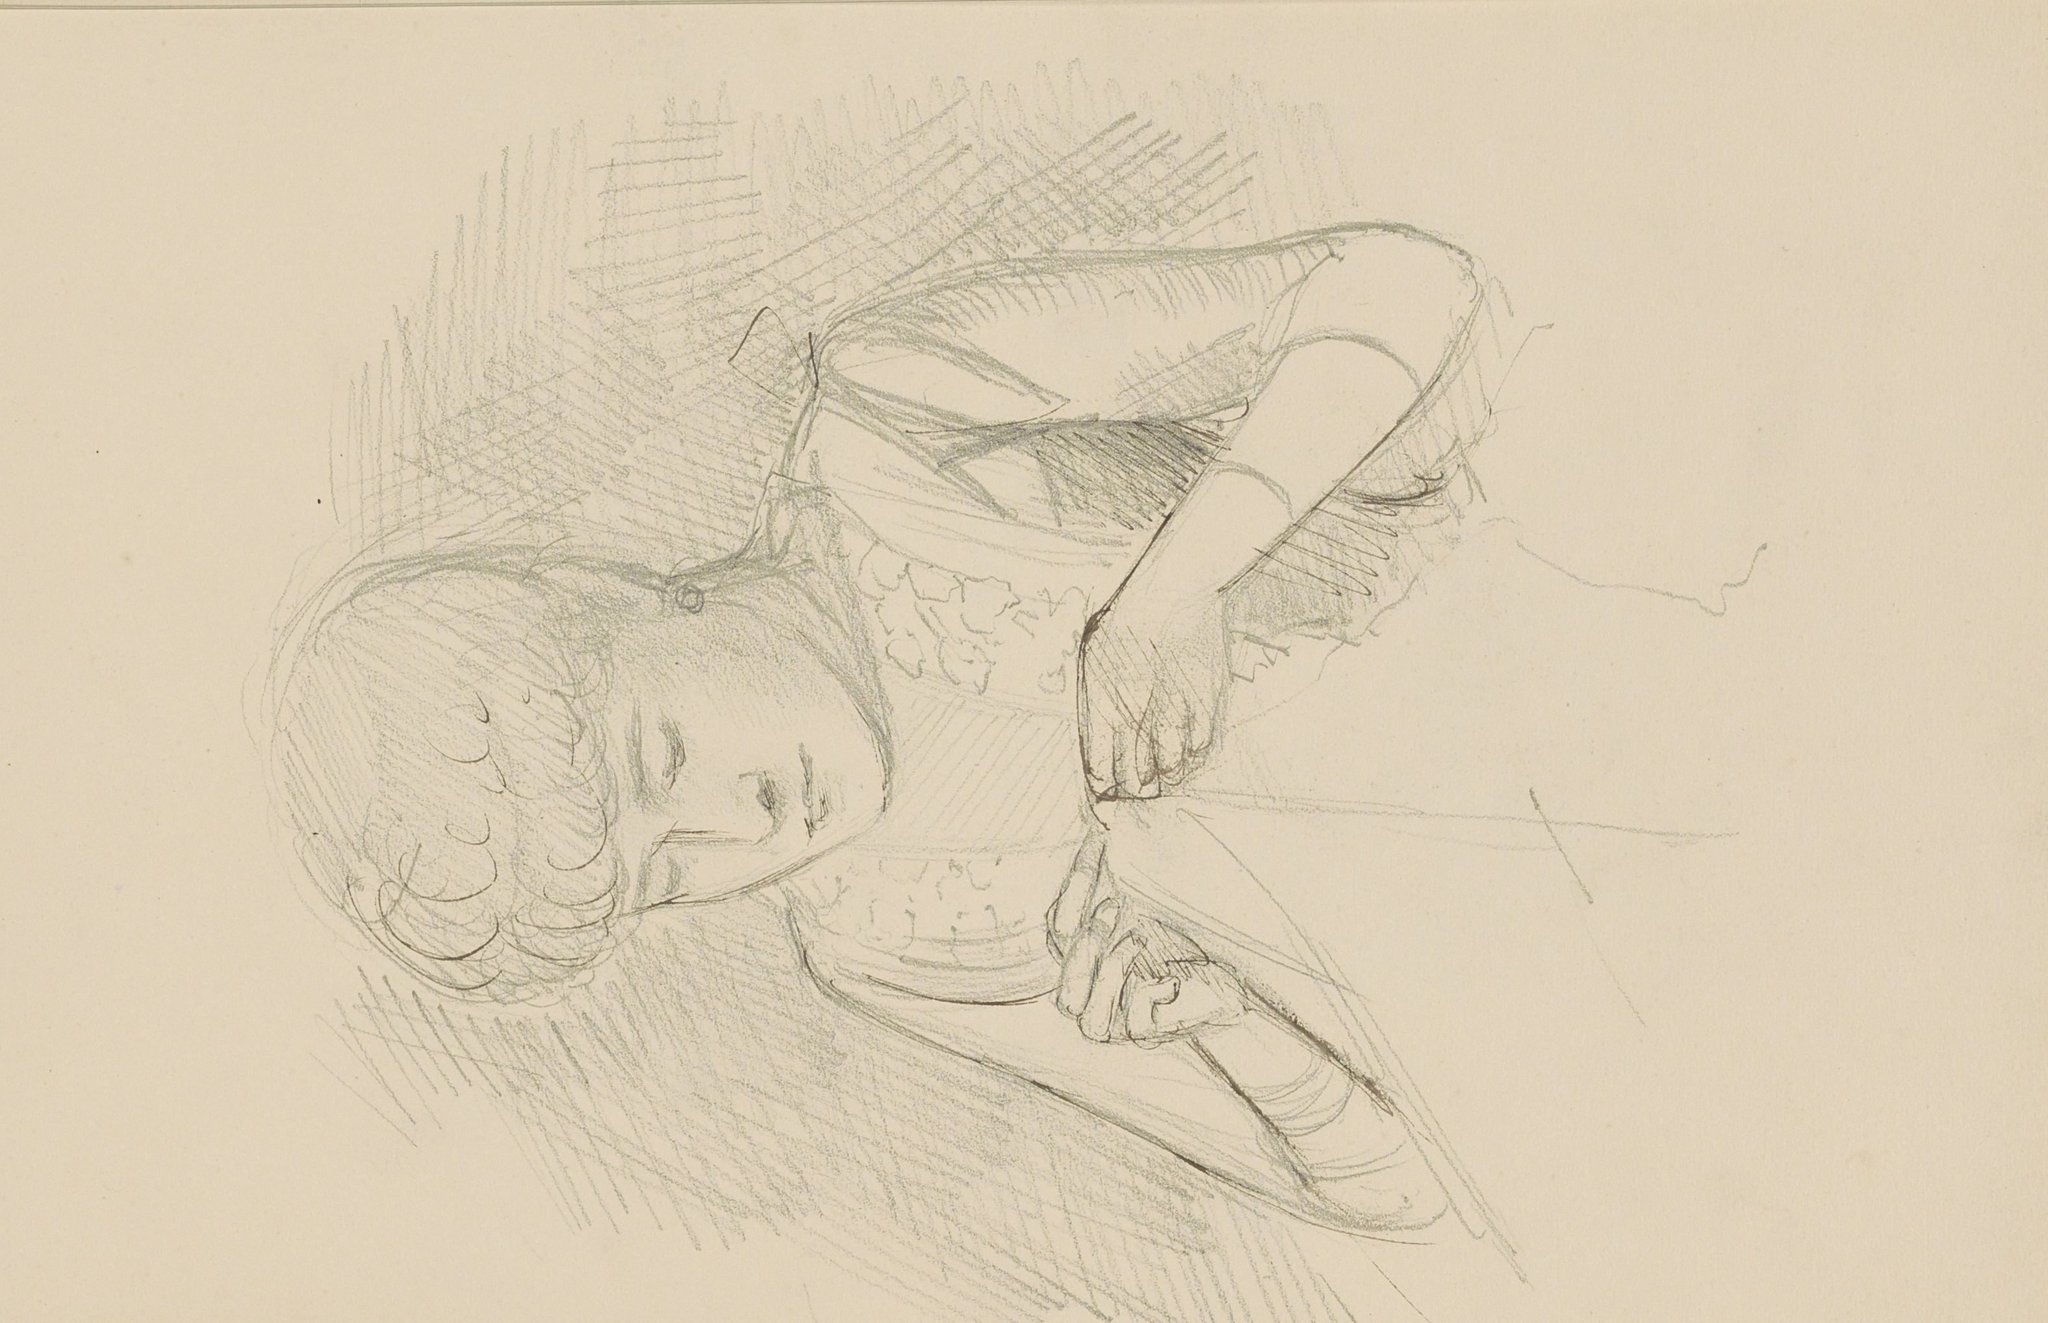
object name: sketchbook leaf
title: Handwerkende vrouw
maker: jozef israëls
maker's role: draughtsman, painter, print maker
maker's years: 1824-1911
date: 1834-1911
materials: ink, paper, pencil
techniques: pen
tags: adult woman, sewing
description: Blad 11 recto uit een schetsboek met 25 bladen.